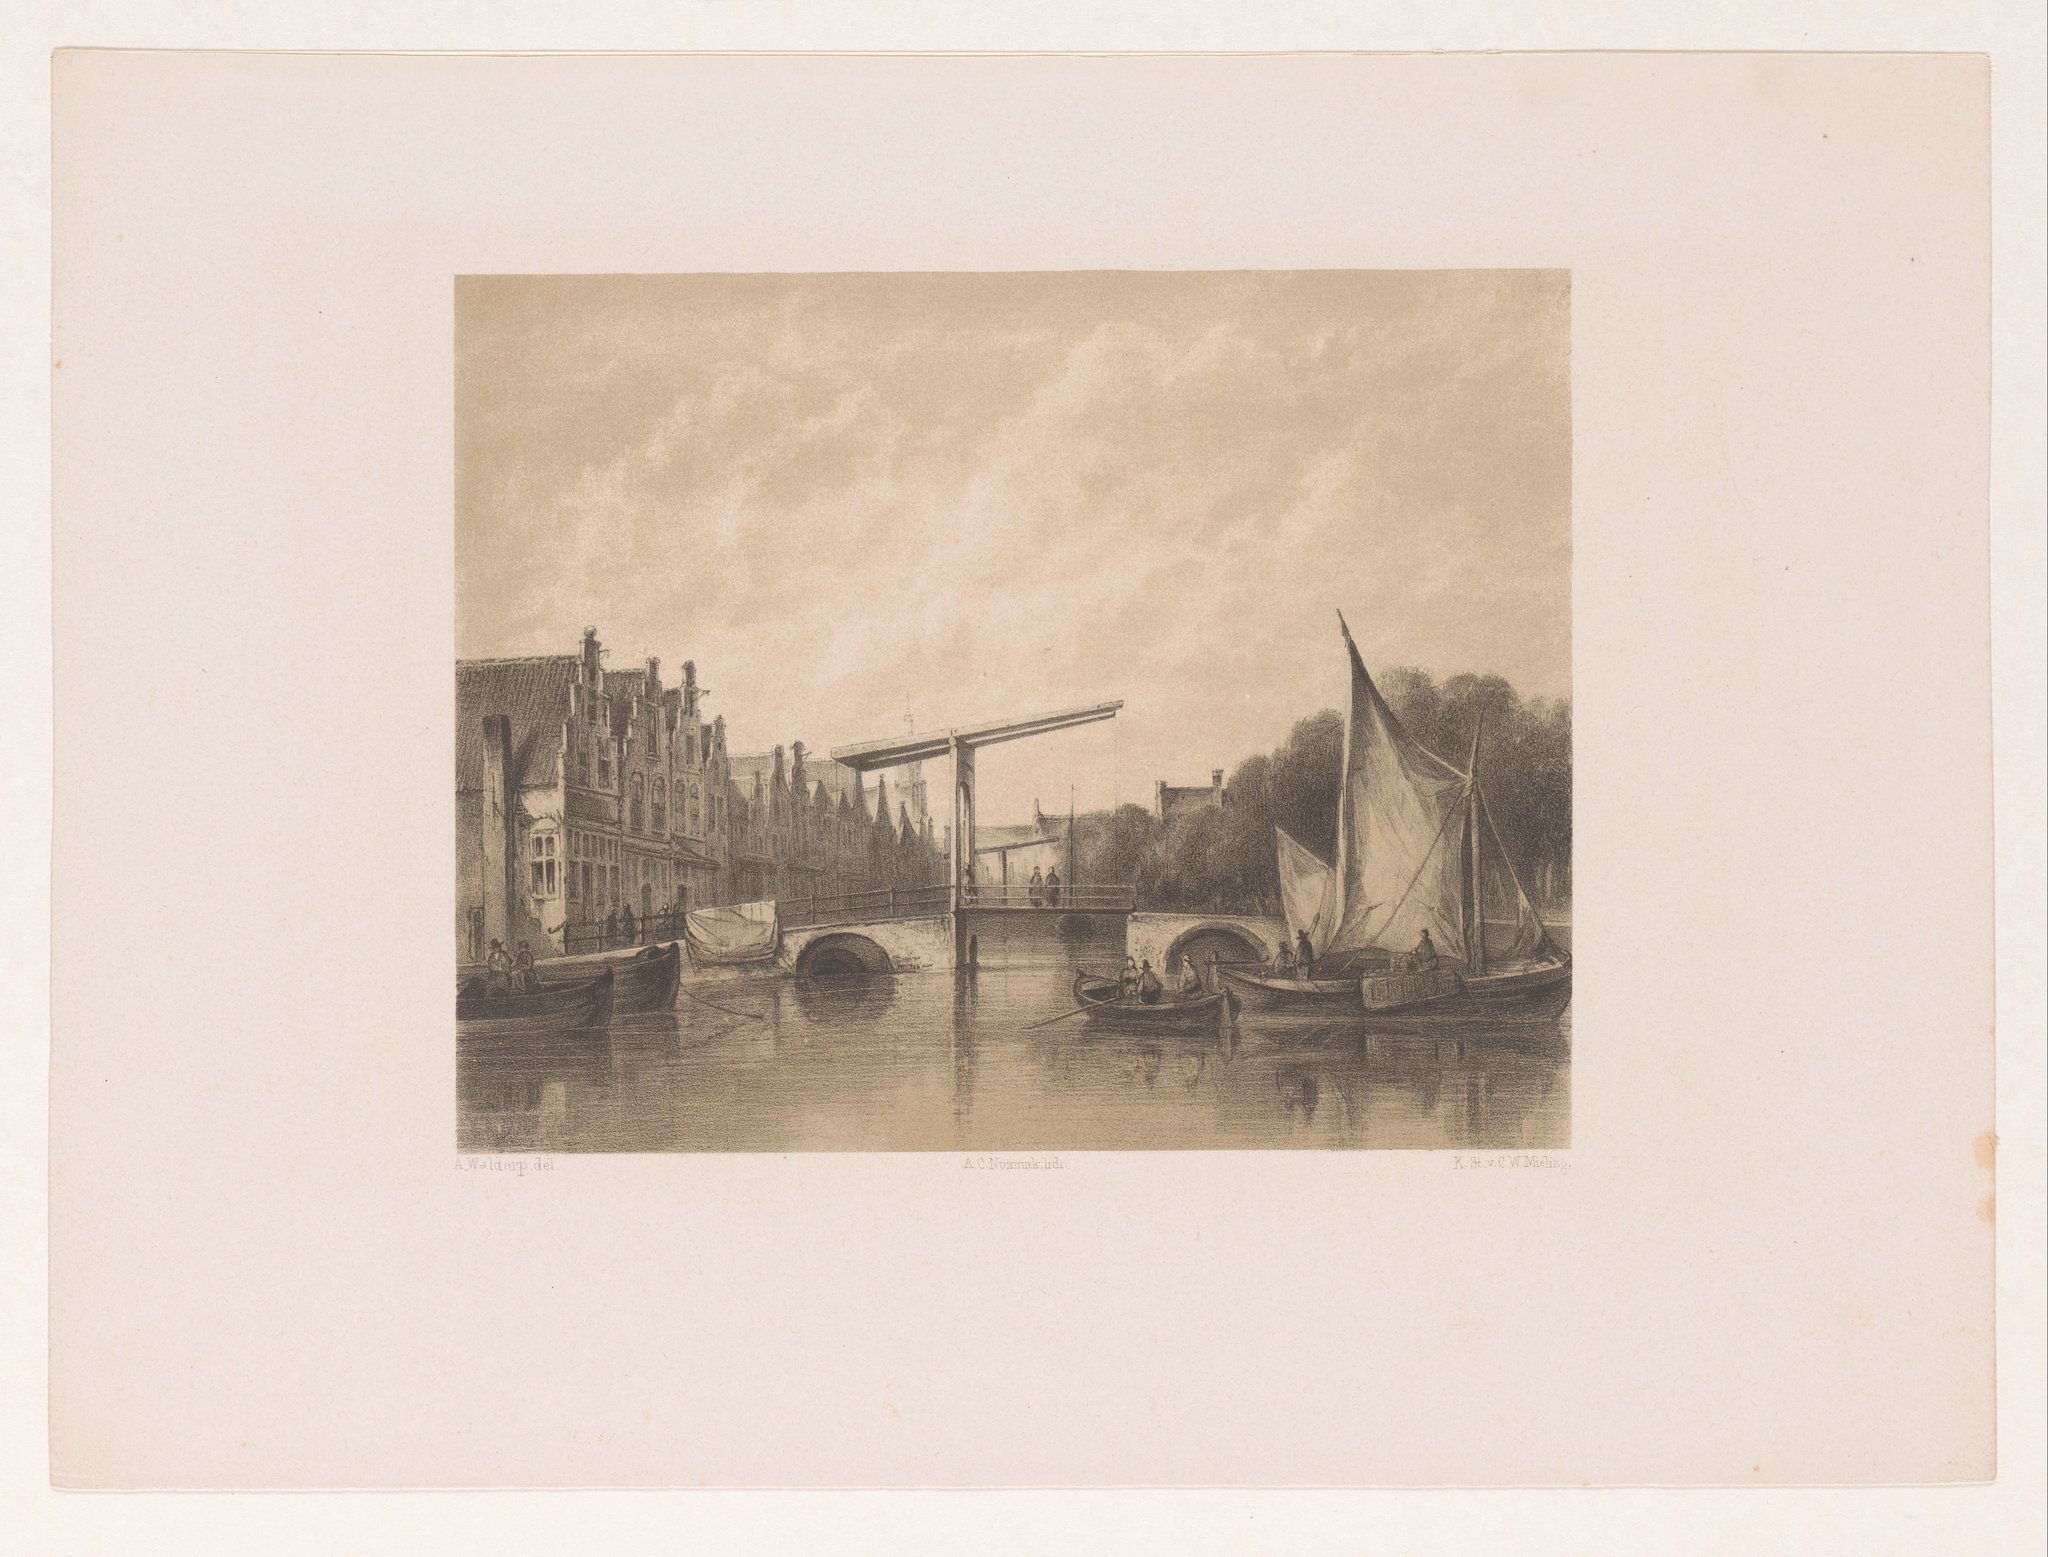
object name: print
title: Gezicht op de Zwanenburgwal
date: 1847-1865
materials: paper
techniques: tone lithography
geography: the hague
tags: city-view in general; 'veduta', bridge, amsterdam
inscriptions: collector's mark: Lugt 2228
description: Gezicht op de Zwanenburgwal met ophaalbrug vanaf de Amstel. In de achtergrond de Zuiderkerk te Amsterdam.